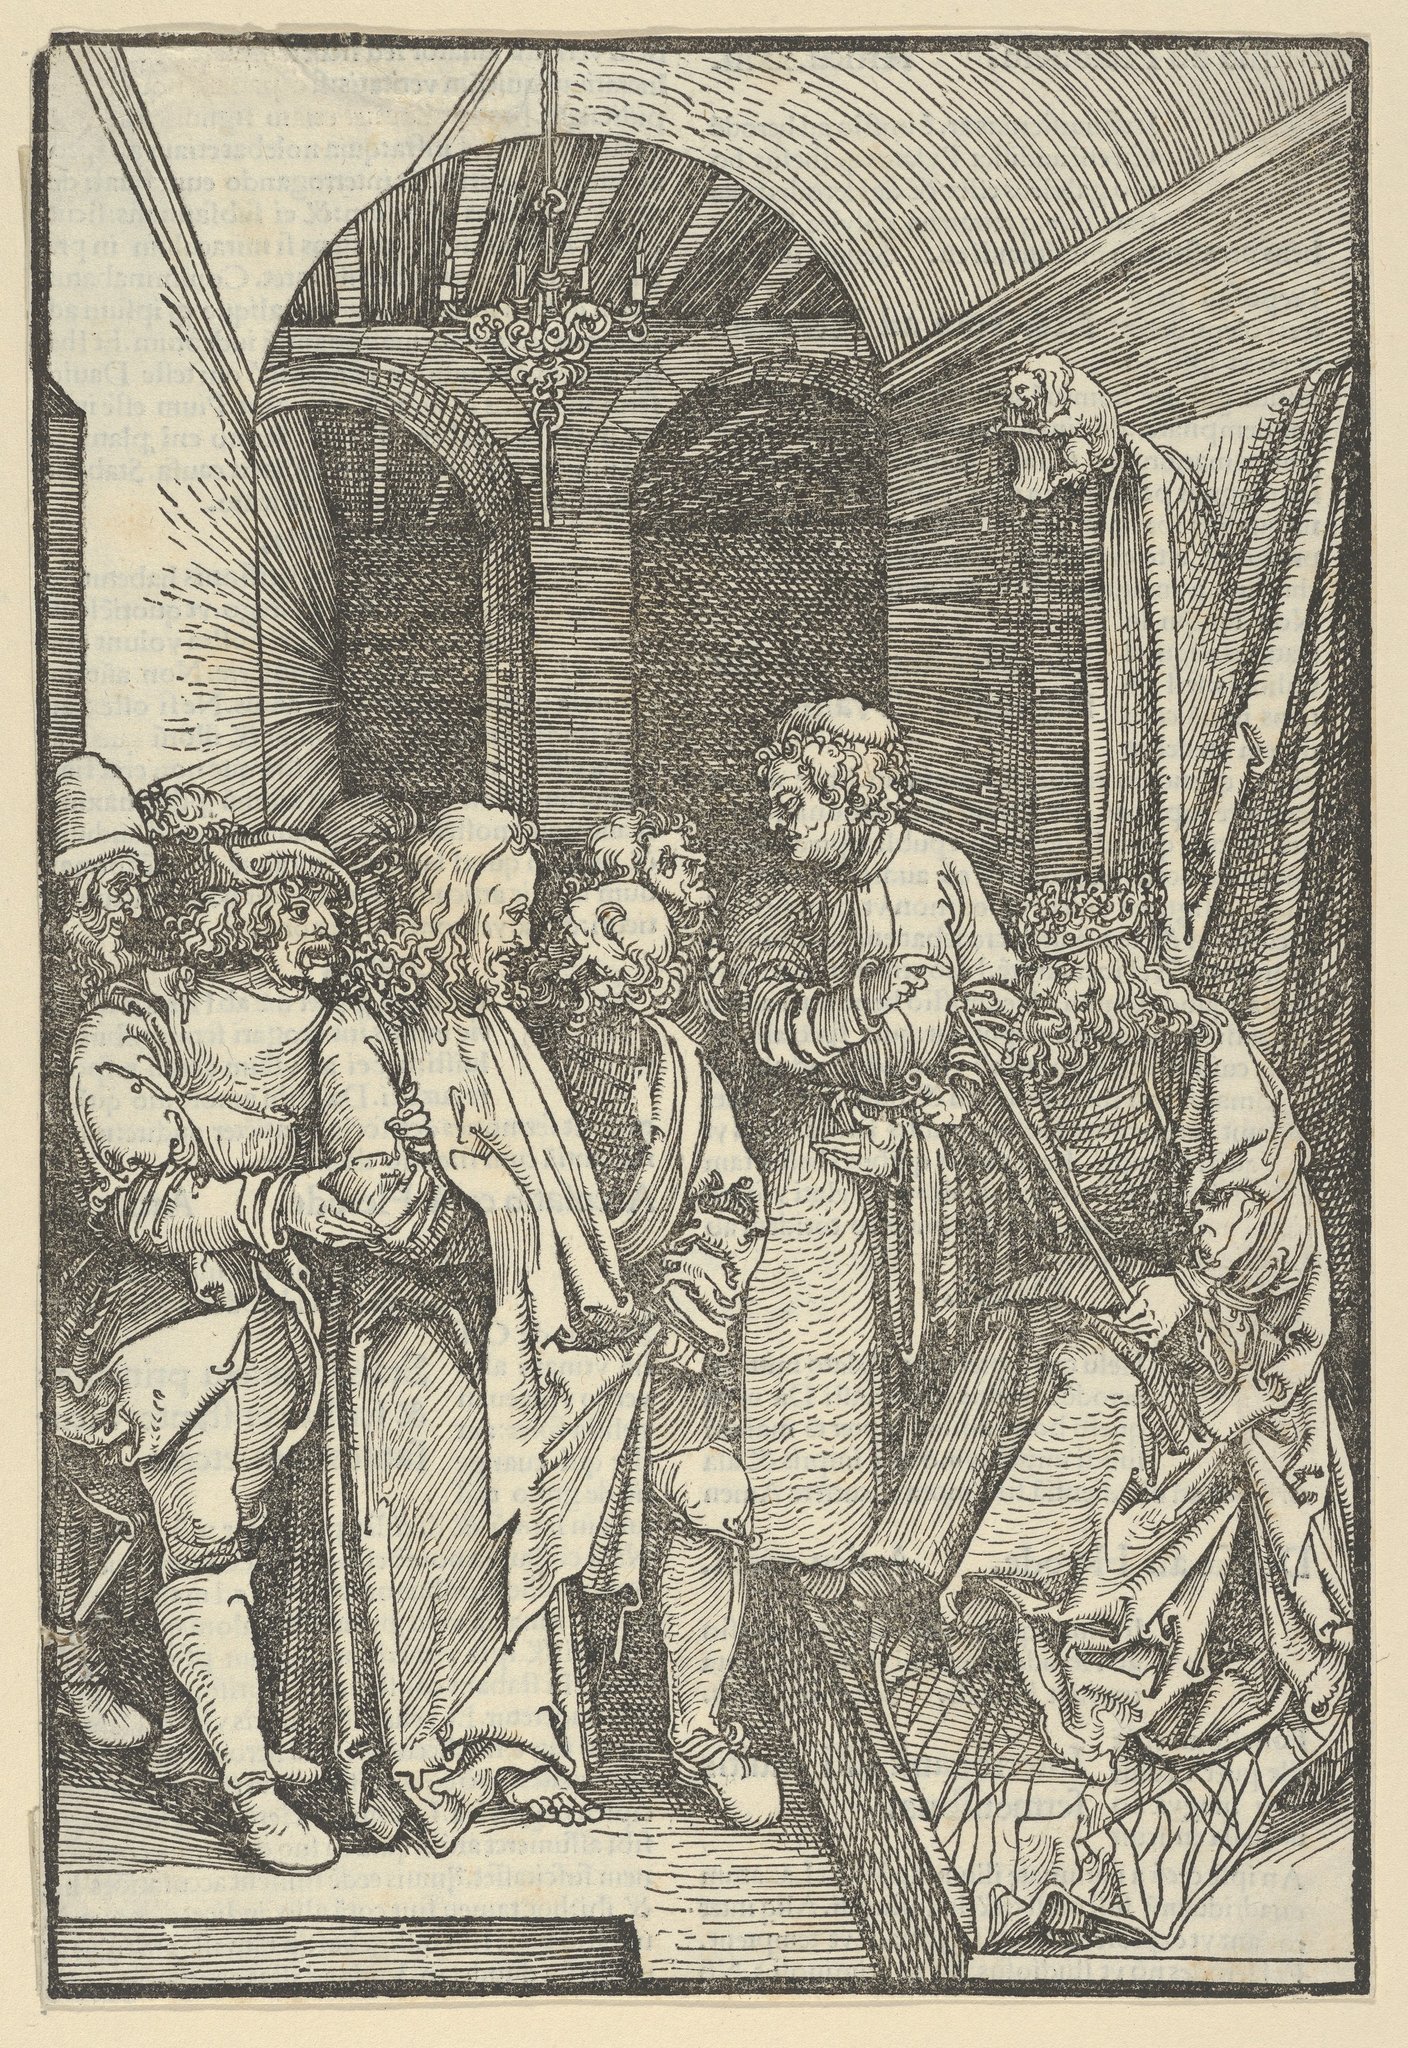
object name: print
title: Christ before Herod in a Hall, from Speculum passionis domini nostri Ihesu Christi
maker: hans schäufelein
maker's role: artist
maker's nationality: german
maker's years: 1480-1540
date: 1507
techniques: woodcut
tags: men,christ